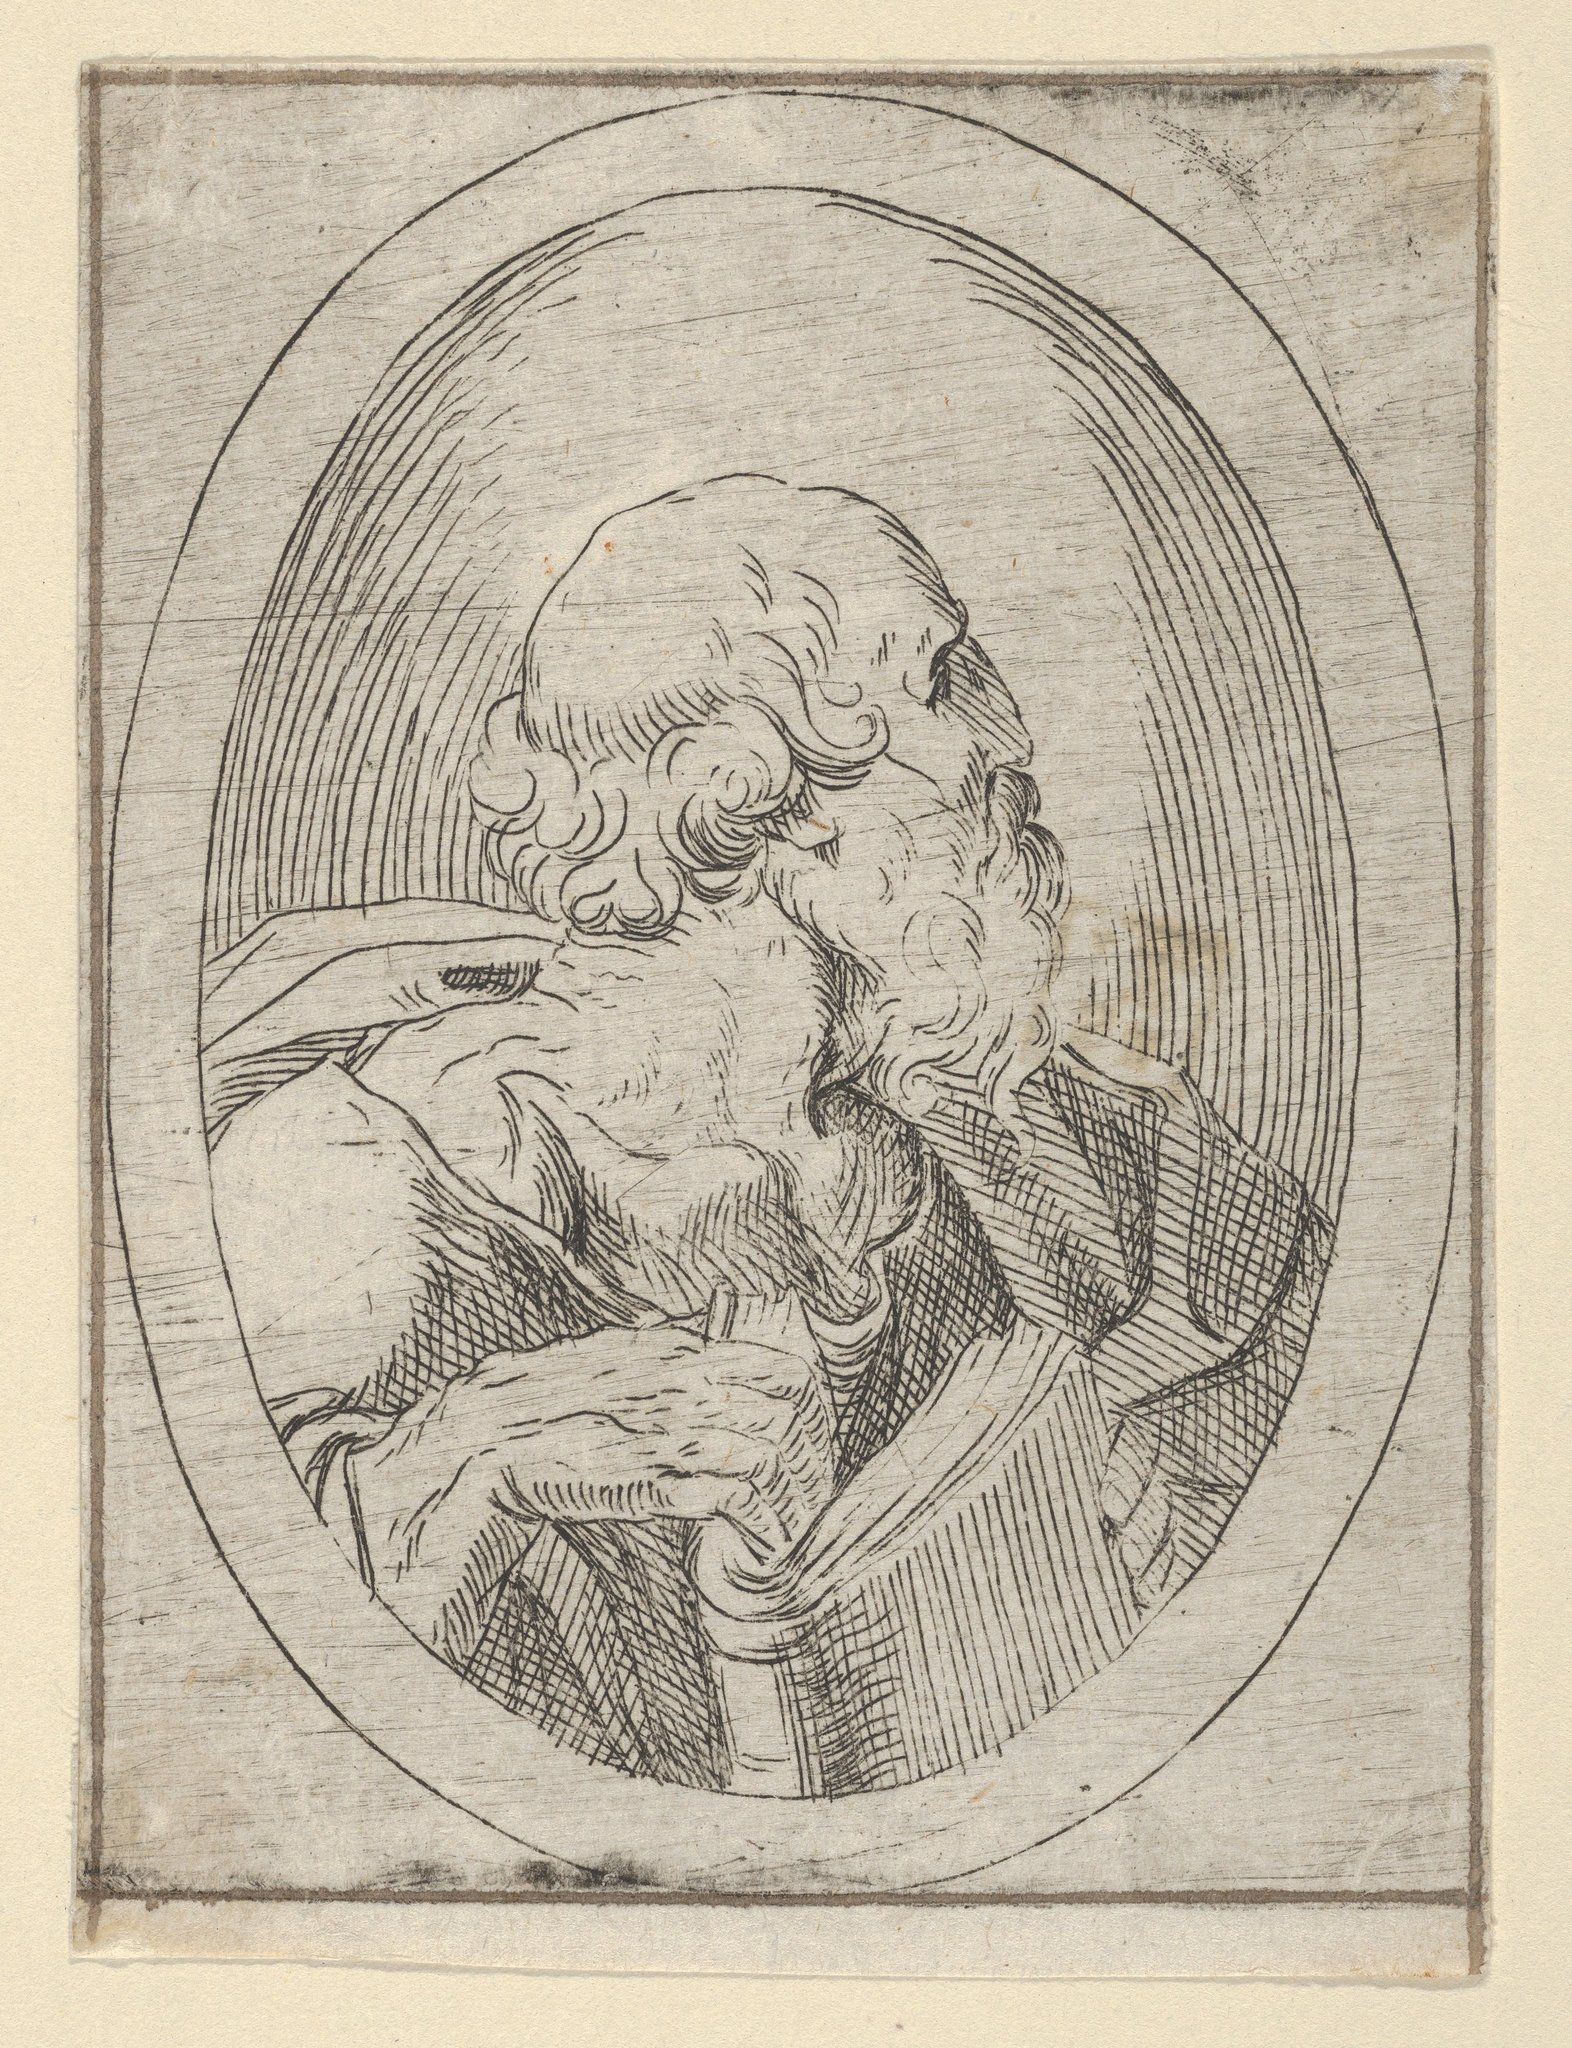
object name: print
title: An apostle seen in profile facing right, holding an open book, in an oval frame, from "Christ, the Virgin, and Thirteen Apostles"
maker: anonymous, 17th century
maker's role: artist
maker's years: 1600-1700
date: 1600-1640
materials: ink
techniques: etching, pen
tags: profiles,apostles